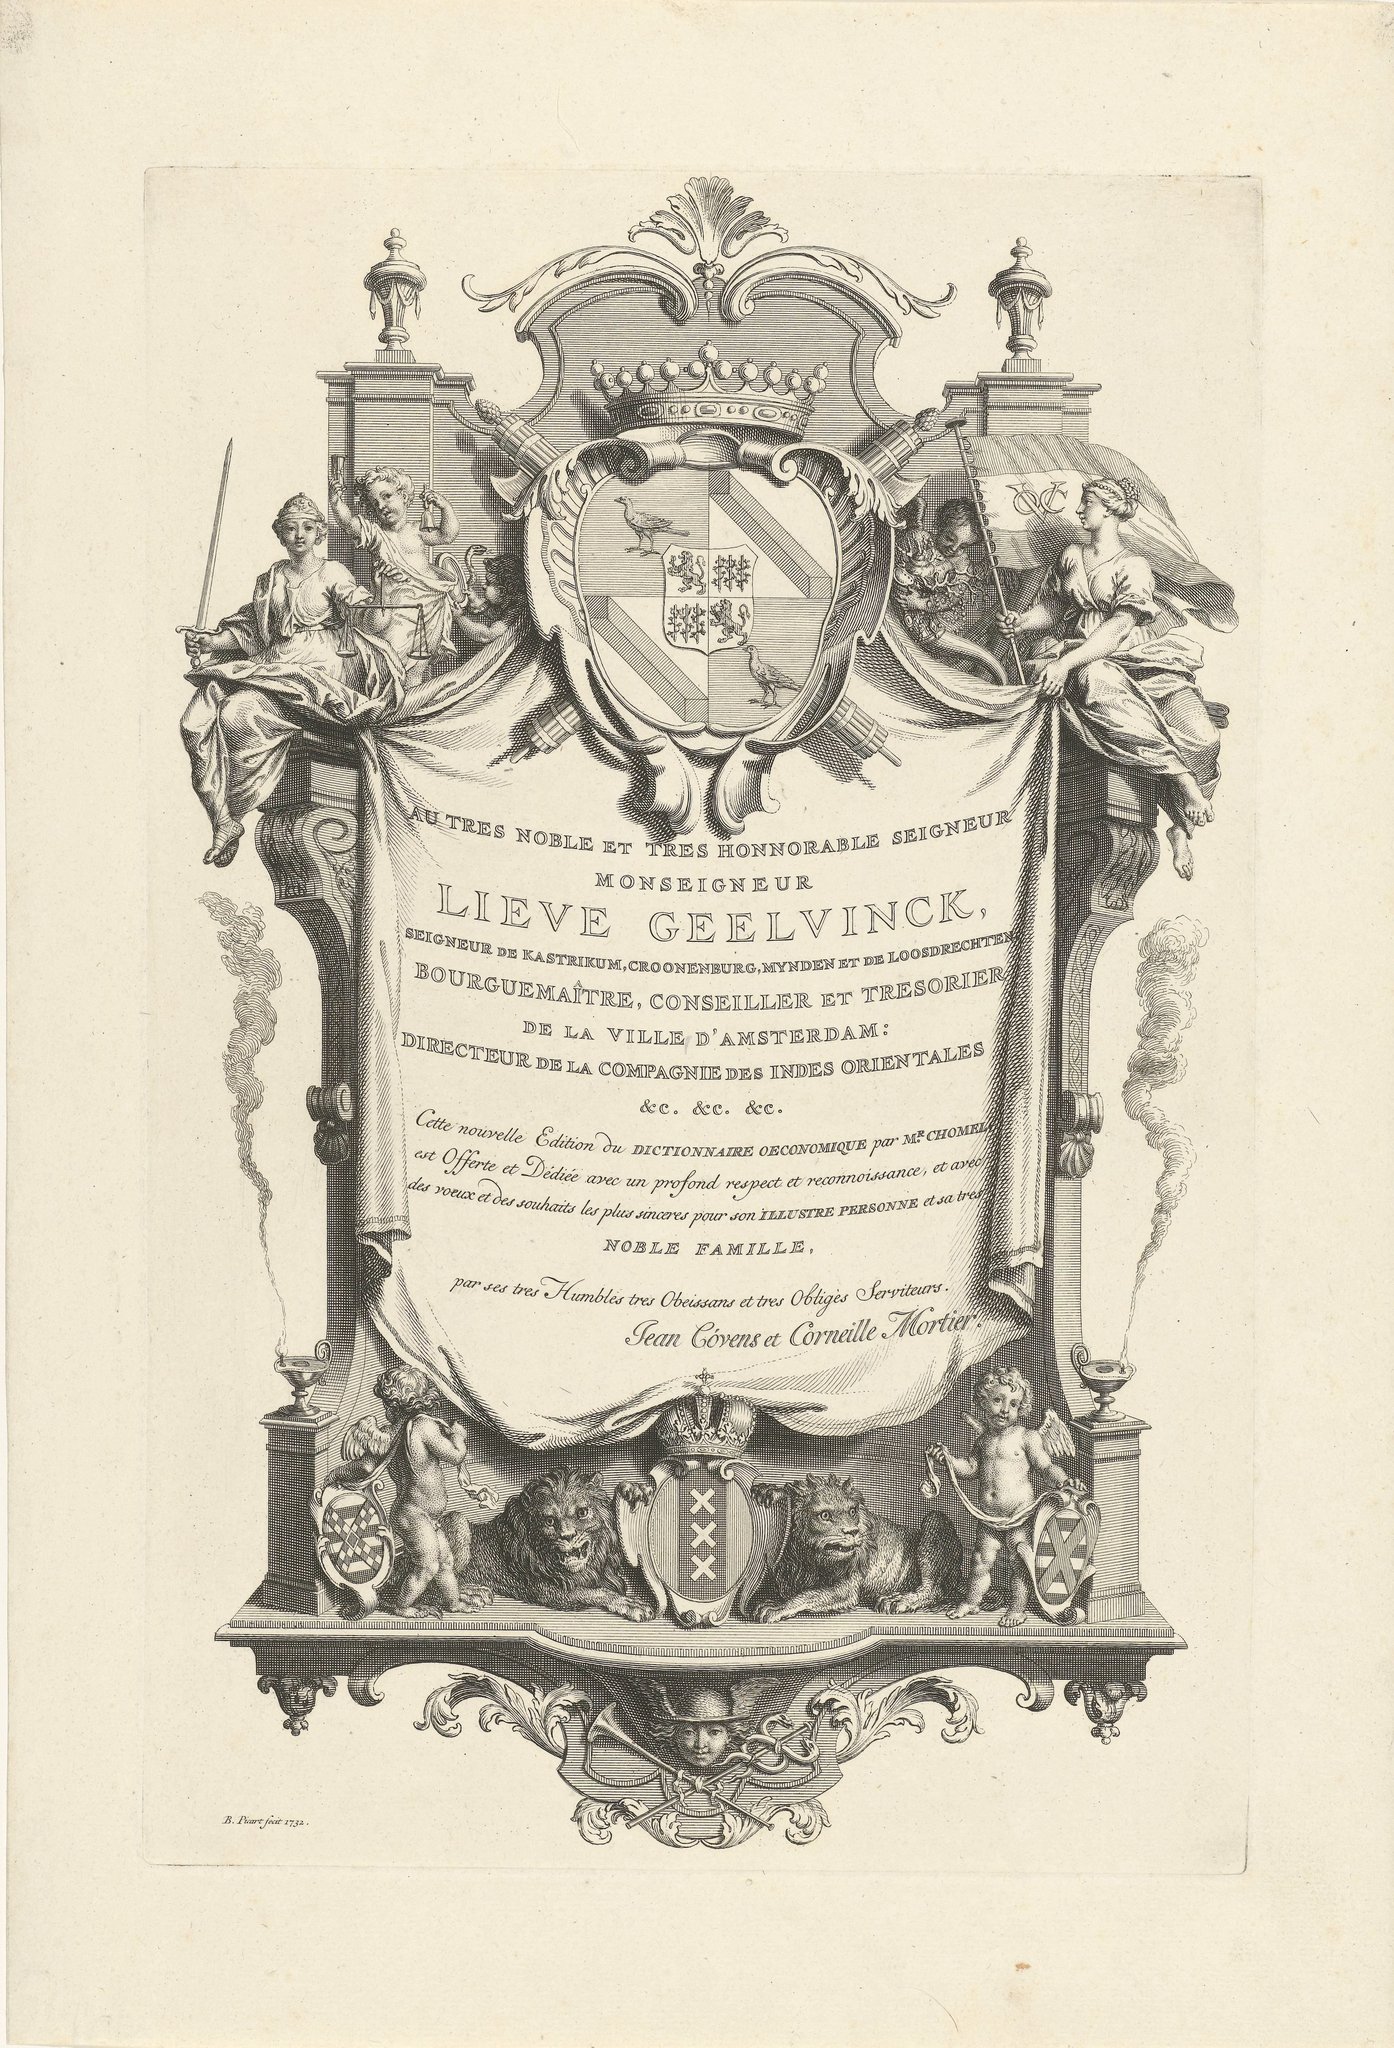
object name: titelblad, titelpagina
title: Titelpagina voor: N. Chomel, Dictionnaire oeconomique, 1732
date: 1732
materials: paper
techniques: engraving, etching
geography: amsterdam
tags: amsterdam, mayor, lieve geelvinck, title-page, justitia (justice) as roman personification, armorial bearing, heraldry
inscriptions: collector's mark: Lugt 2228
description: Cartouche met het wapenschild van Lieve Geelvinck, burgemeester van Amsterdam. Zijn wapen wordt geflankeerd door Rechtvaardigheid en de vrouwelijke personificatie van de VOC. Op een draperie de titel van het boek en een opdracht van de uitgevers in het Frans. Daaronder het wapenschild van de stad Amsterdam.